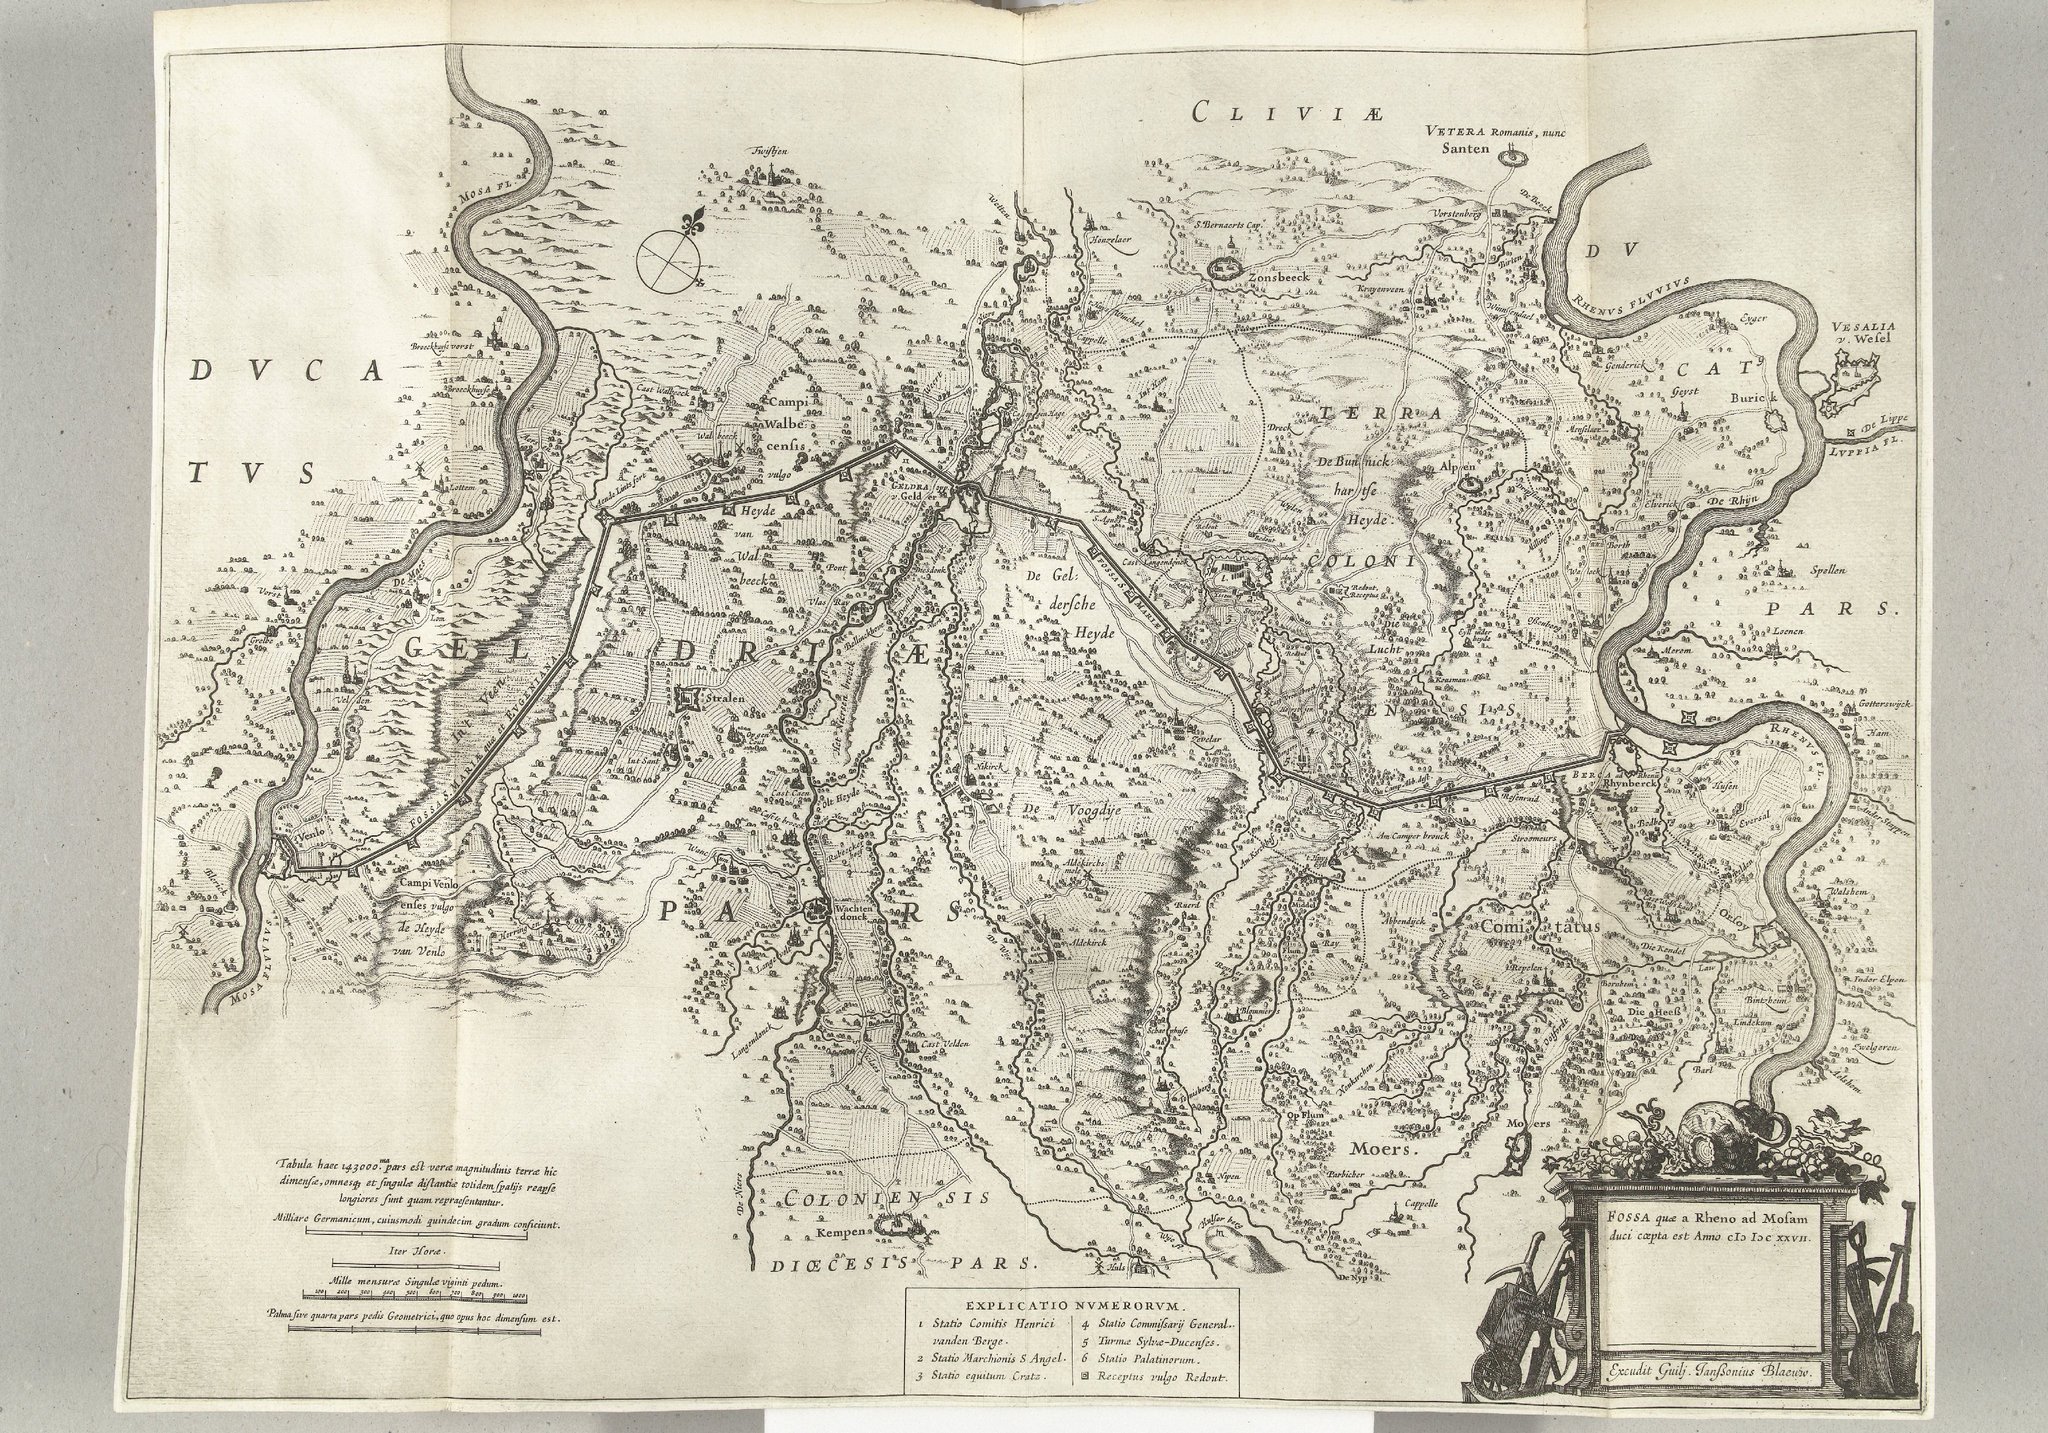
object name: map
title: Fossa quae a Rheno ad Mosam duci coepta est Anno MDCXXVII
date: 1629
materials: paper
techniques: etching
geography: amsterdam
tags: construction of canal, maps of separate countries or regions, guelders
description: Kaart met het kanaal genaamd Fossa Eugeniana tussen Rijnberg aan de Rijn en Venlo aan de Maas. Onderaan de schalen, verklaring 1-6 en een cartouche met de titel, alles in het Latijn. Onderdeel van de platen bij het verslag van het beleg en de verovering van Grol door het Staatse Leger onder Frederik Hendrik, 6 juli tot 19 augustus 1627.